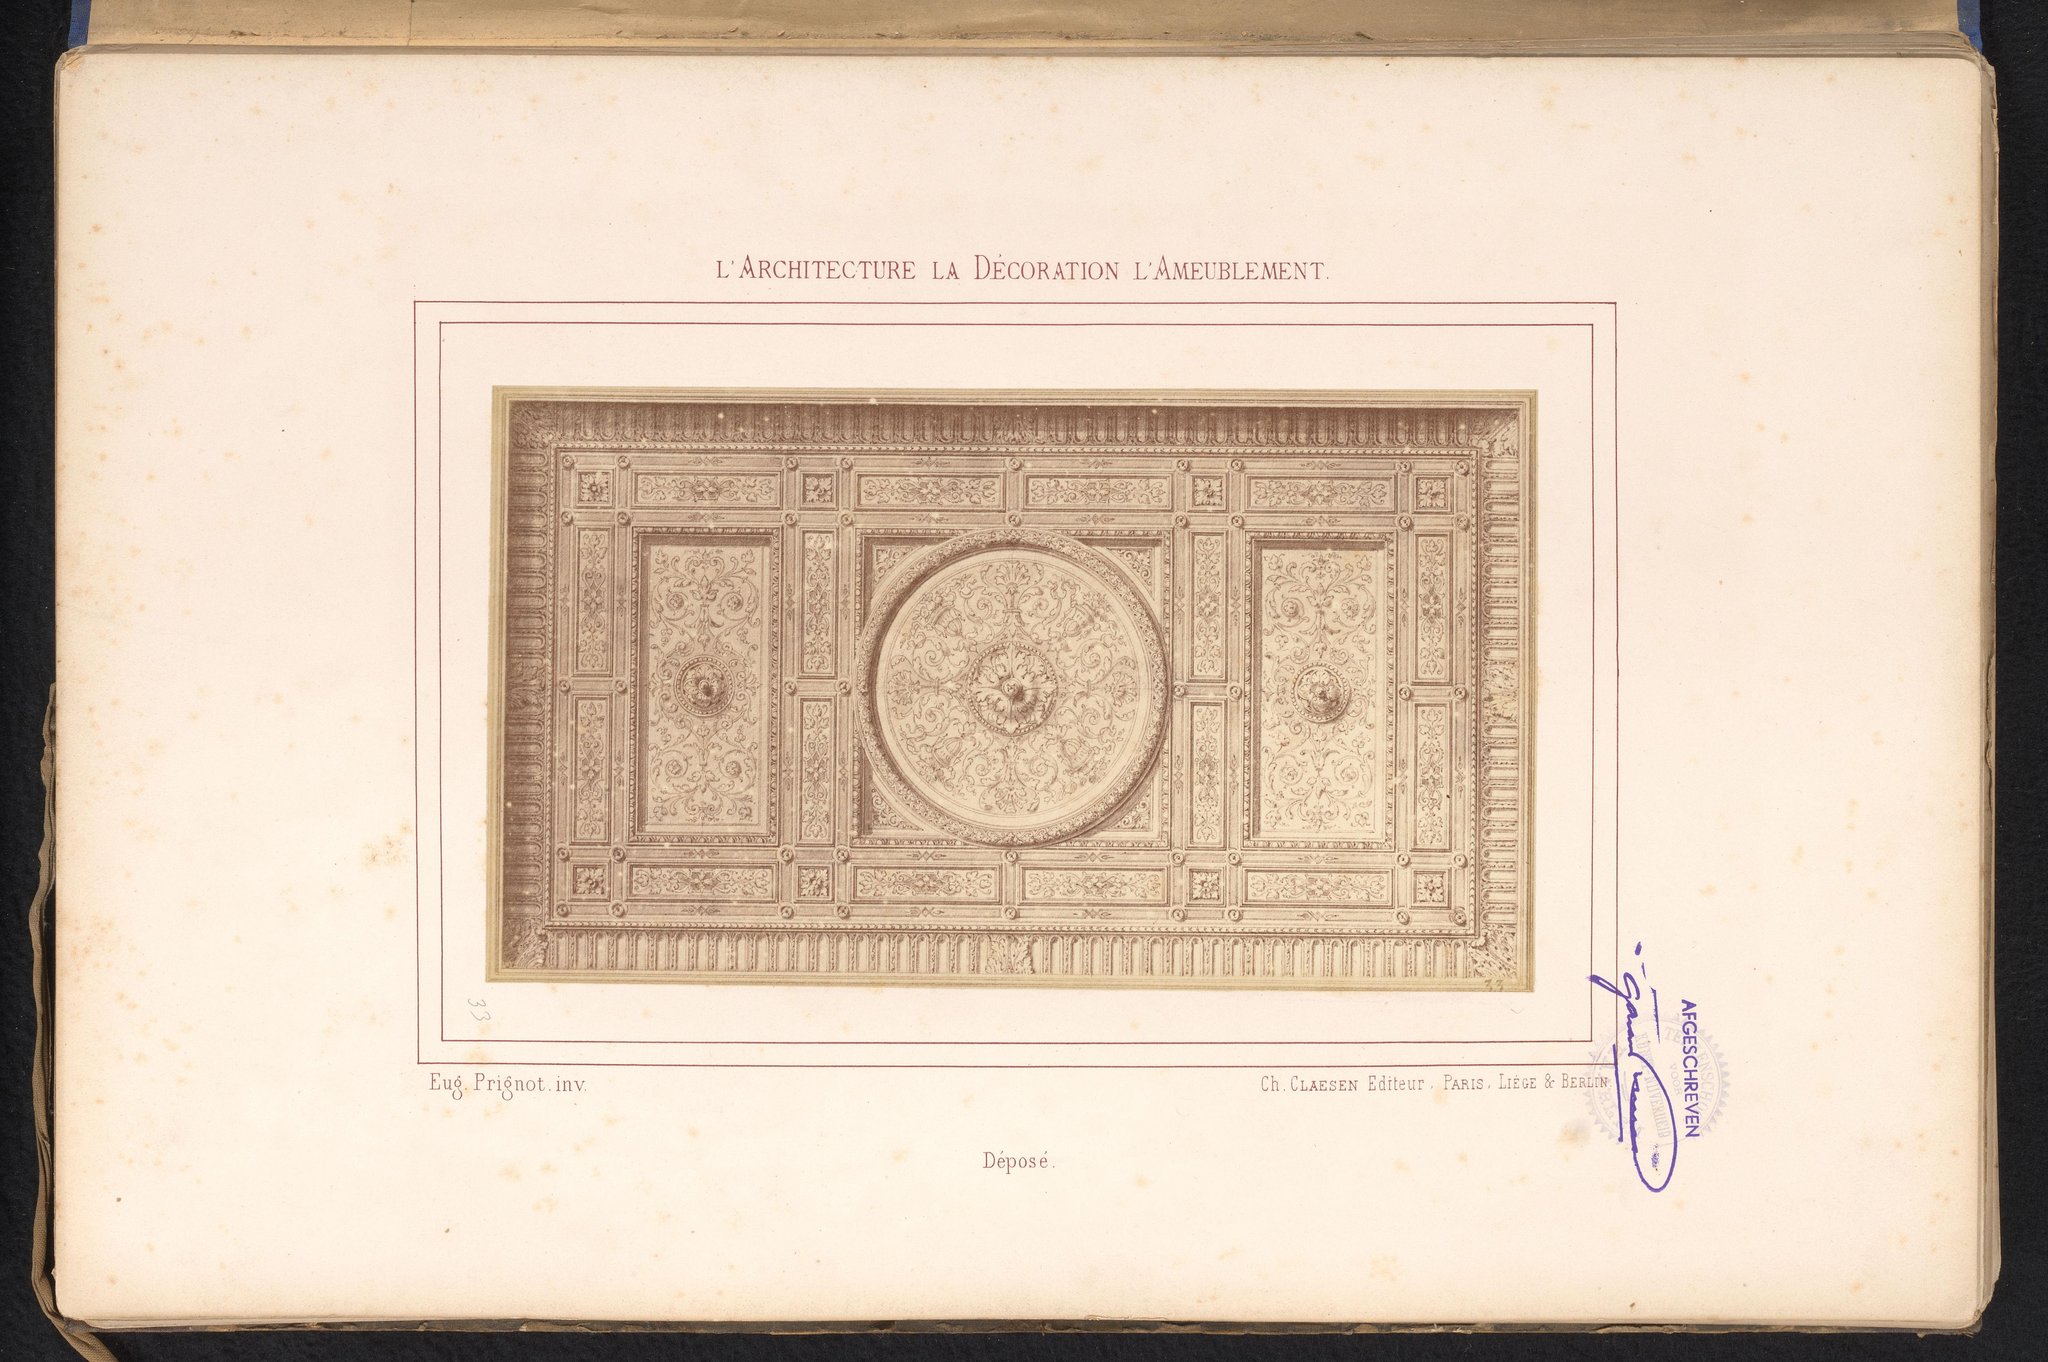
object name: photograph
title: Fotoreproductie van een ontwerp voor een plafond naar Alexandre Eugène Prignot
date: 1873-1880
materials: cardboard, paper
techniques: albumen print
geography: liège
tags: (decorated) ceiling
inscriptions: inscription: ‘Déposé’, stamp: ‘TEEKENSCHOOL/ VOOR/ KUNST-NIJVERHEID/ HAARLEM’, number: ‘33’, inscription: ‘Eug. Prignot. inv.’, stamp: ‘AFGESCHREVEN/ [...]’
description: Deze foto maakt deel uit van een omslag met 61 foto's op 61 bladen.